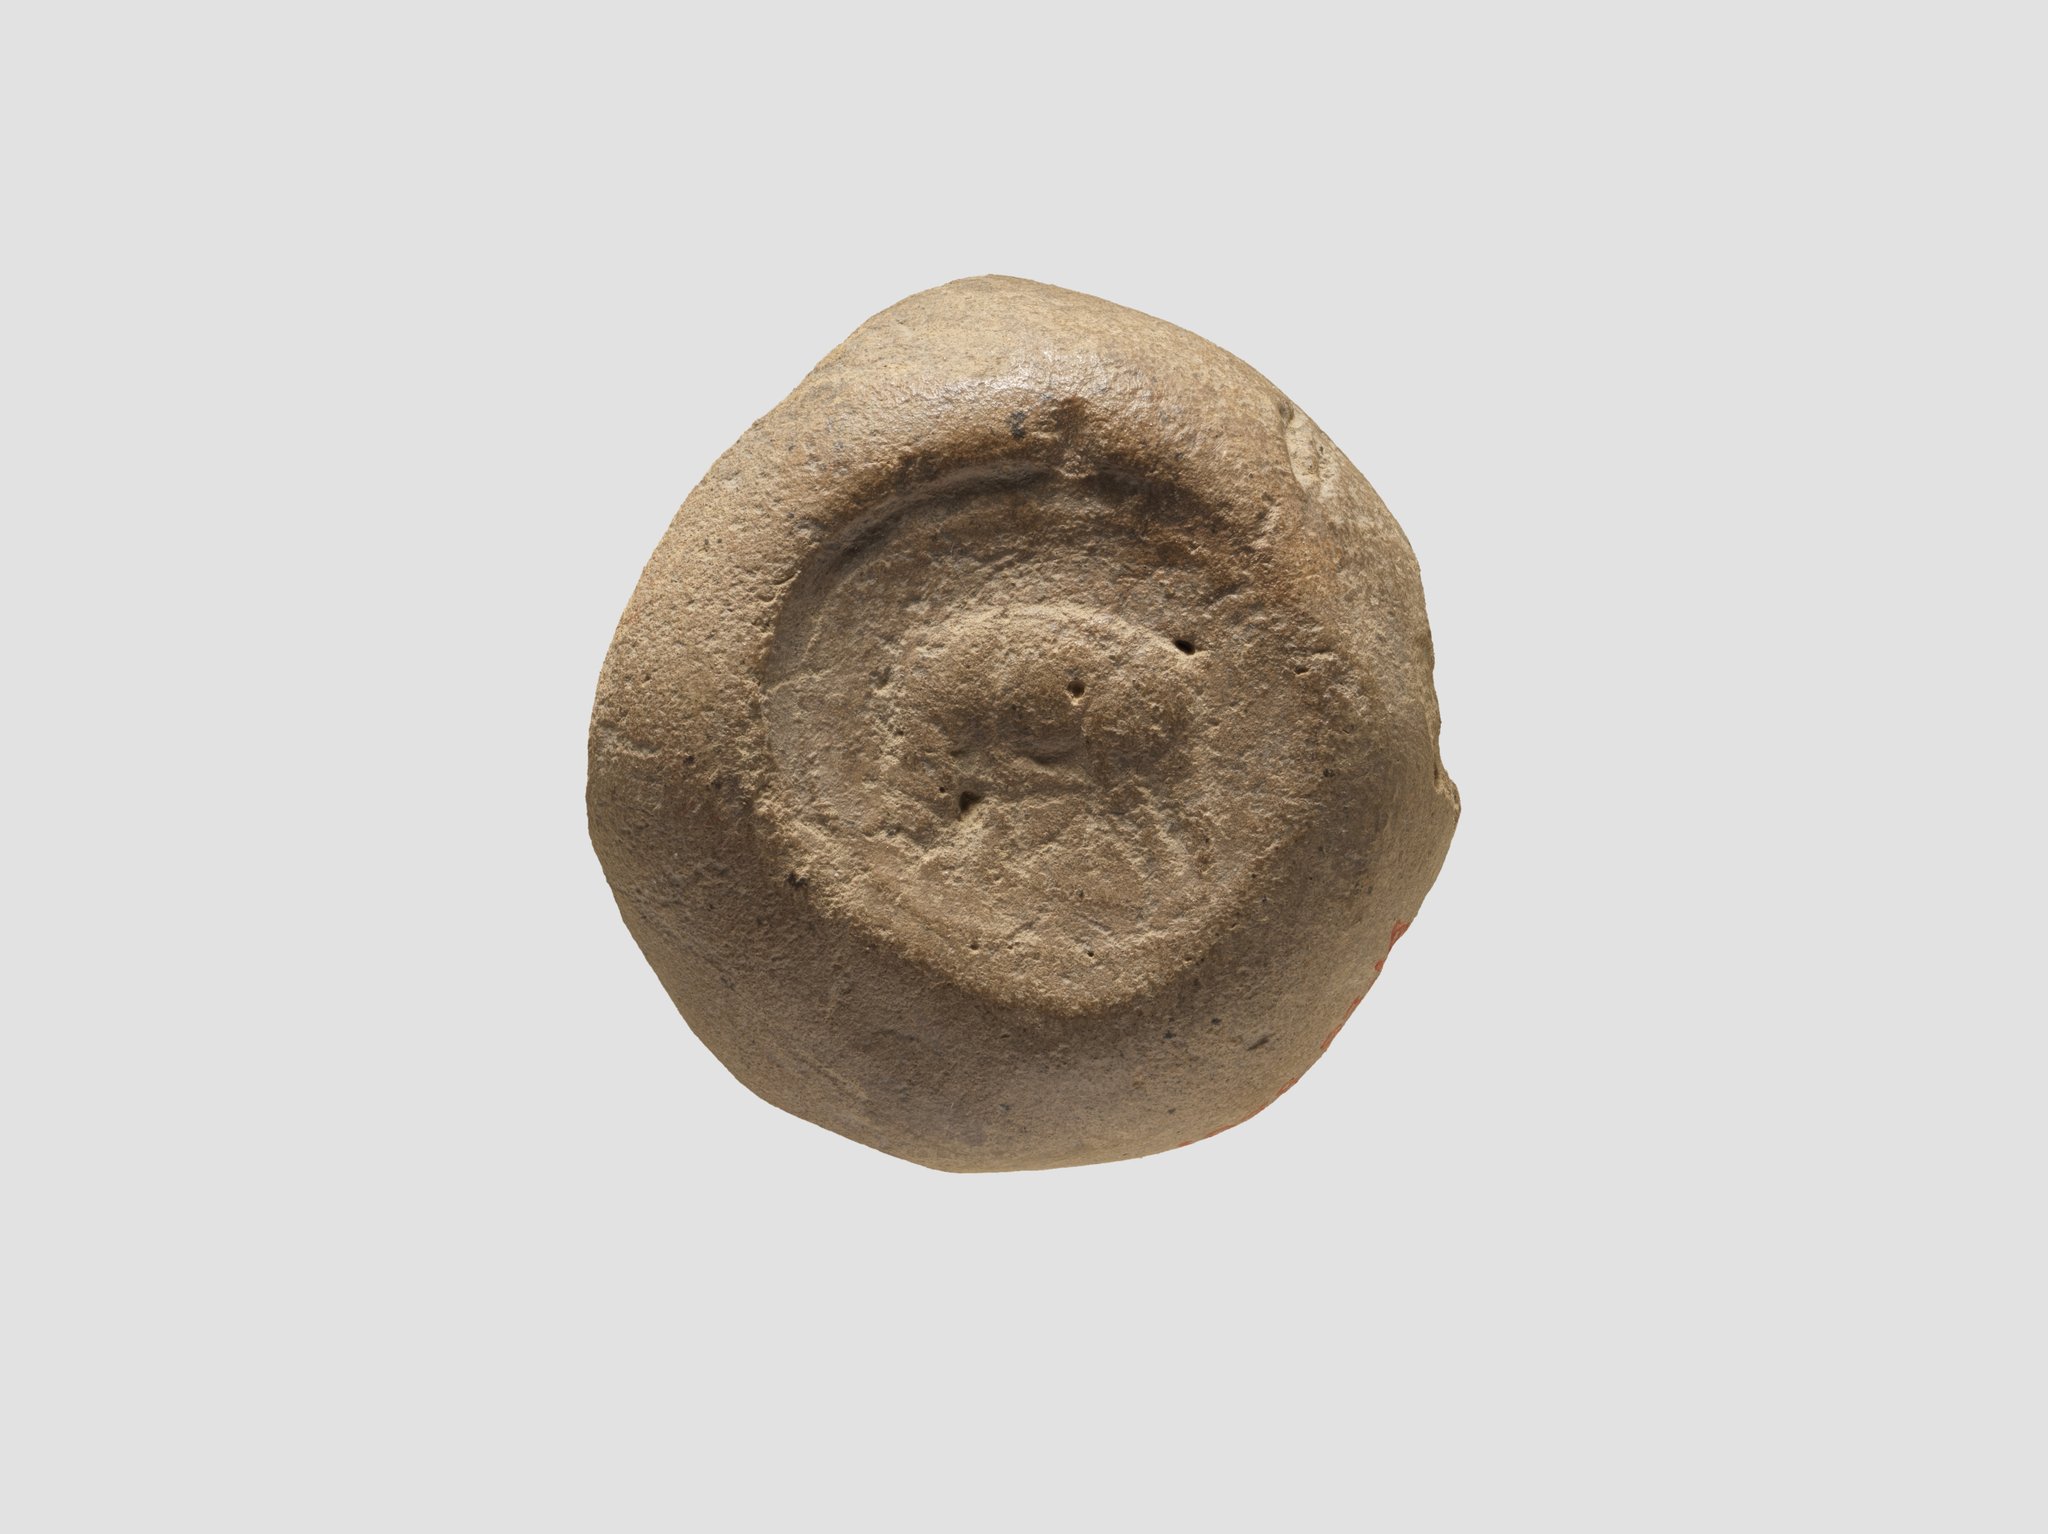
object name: bulla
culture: achaemenid or seleucid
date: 500-168 BCE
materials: clay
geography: iran